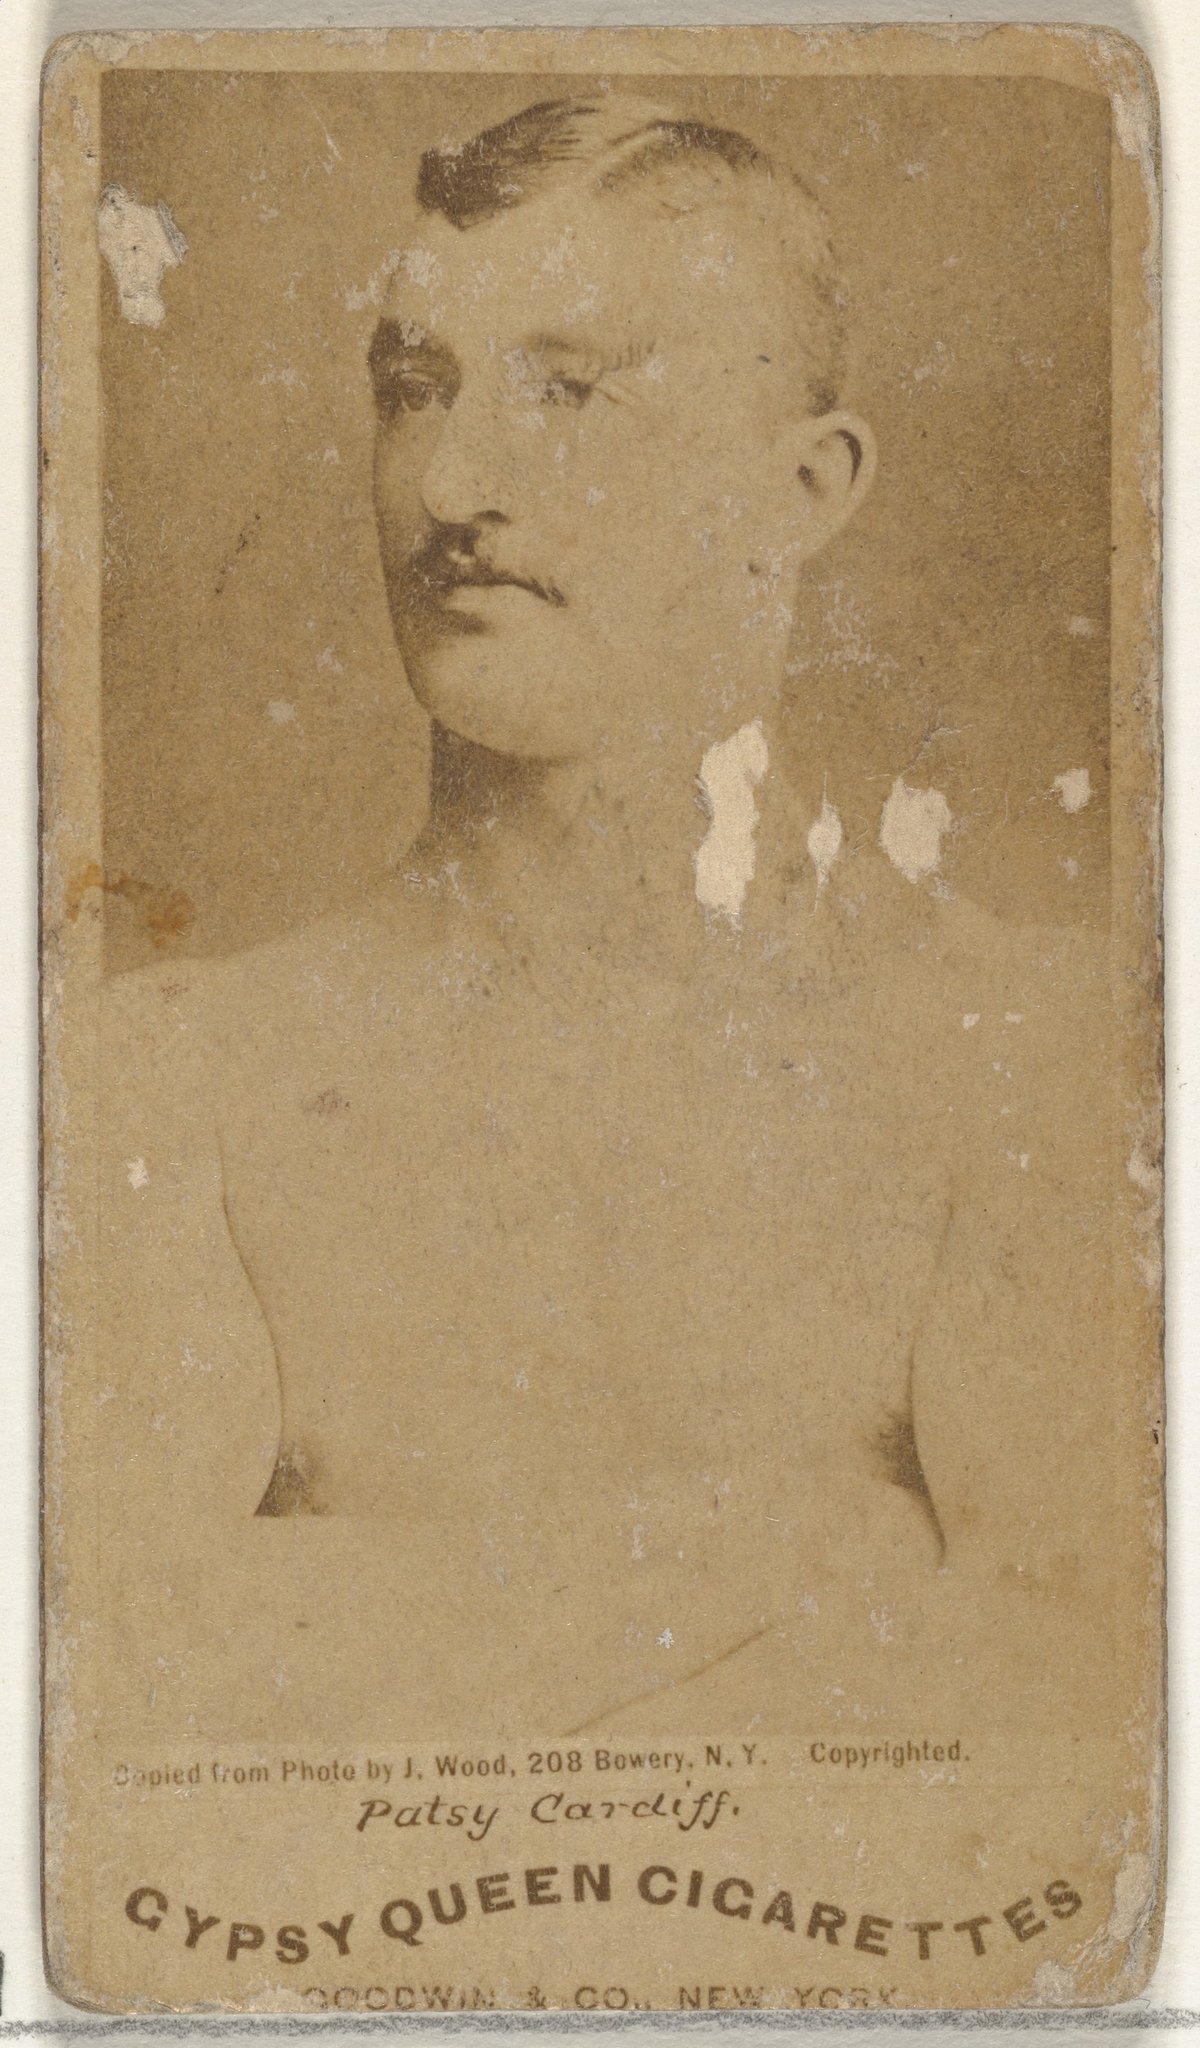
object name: photograph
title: Patsy Cardiff, from the Celebrities and Prizefighters series (N174) for Gypsy Queen Cigarettes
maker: goodwin & company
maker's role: publisher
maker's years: 1850-1950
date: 1887-1888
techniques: albumen silver print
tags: men,portraits,boxing,athletes